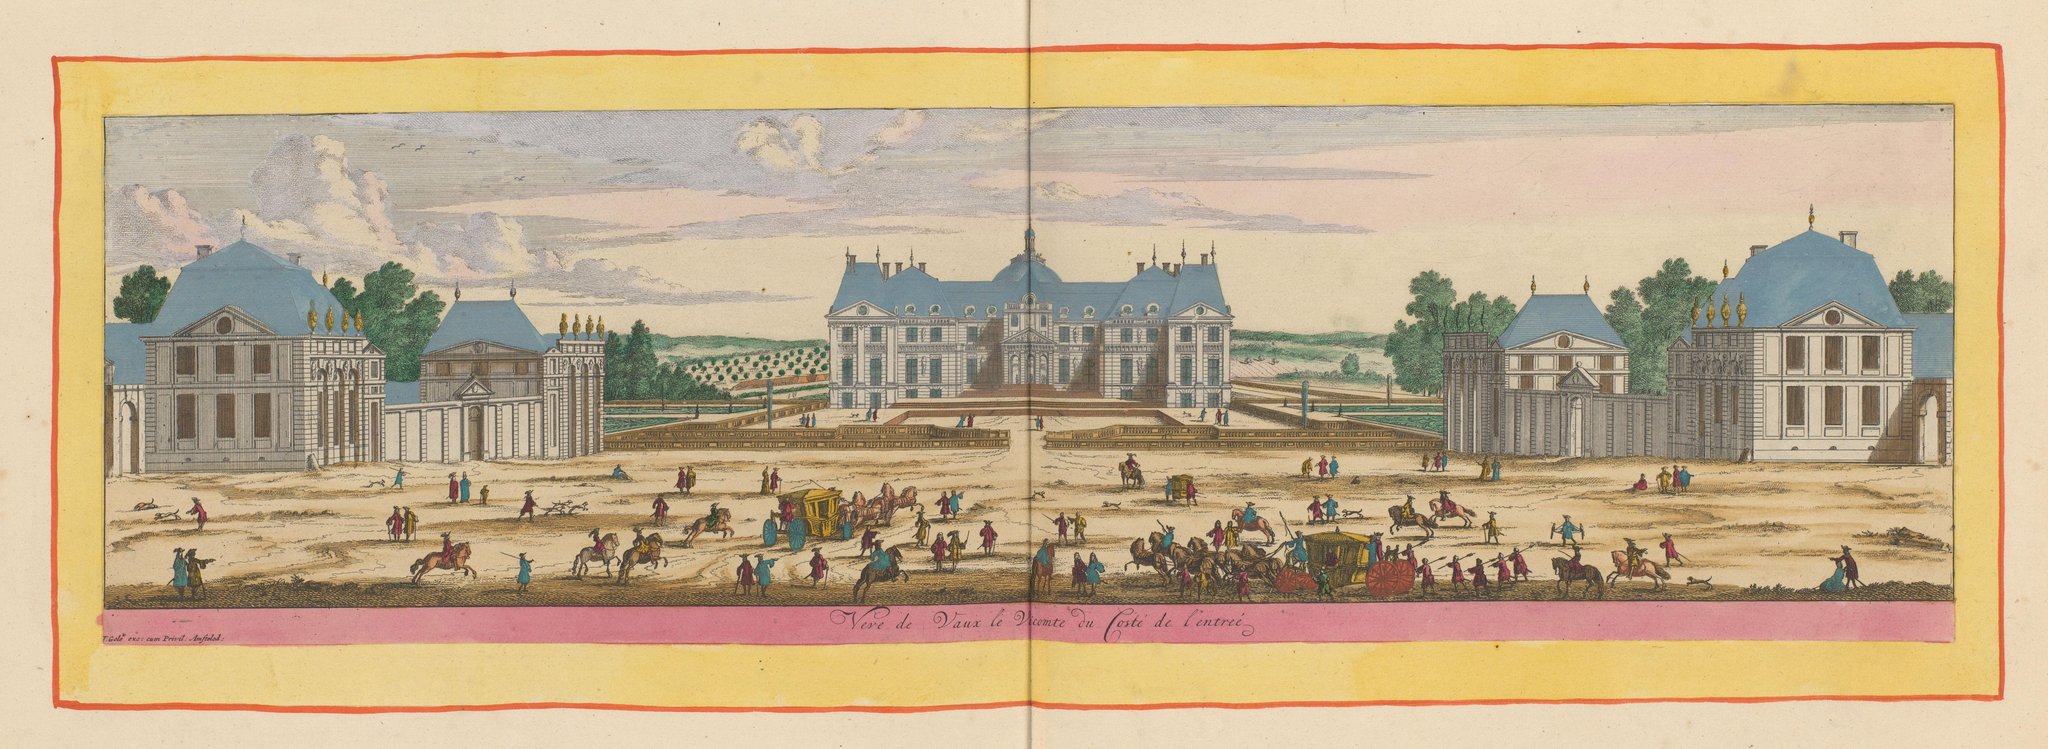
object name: album leaf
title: Gezicht op Château de Vaux-le-Vicomte vanaf de toegangsweg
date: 1681-1724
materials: paper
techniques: etching, hand coloring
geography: the hague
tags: castle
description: Gezicht op Château de Vaux-le-Vicomte vanaf de toegangsweg. Op de voorgrond ruiters en koetsen. Prent maakt deel uit van een album.